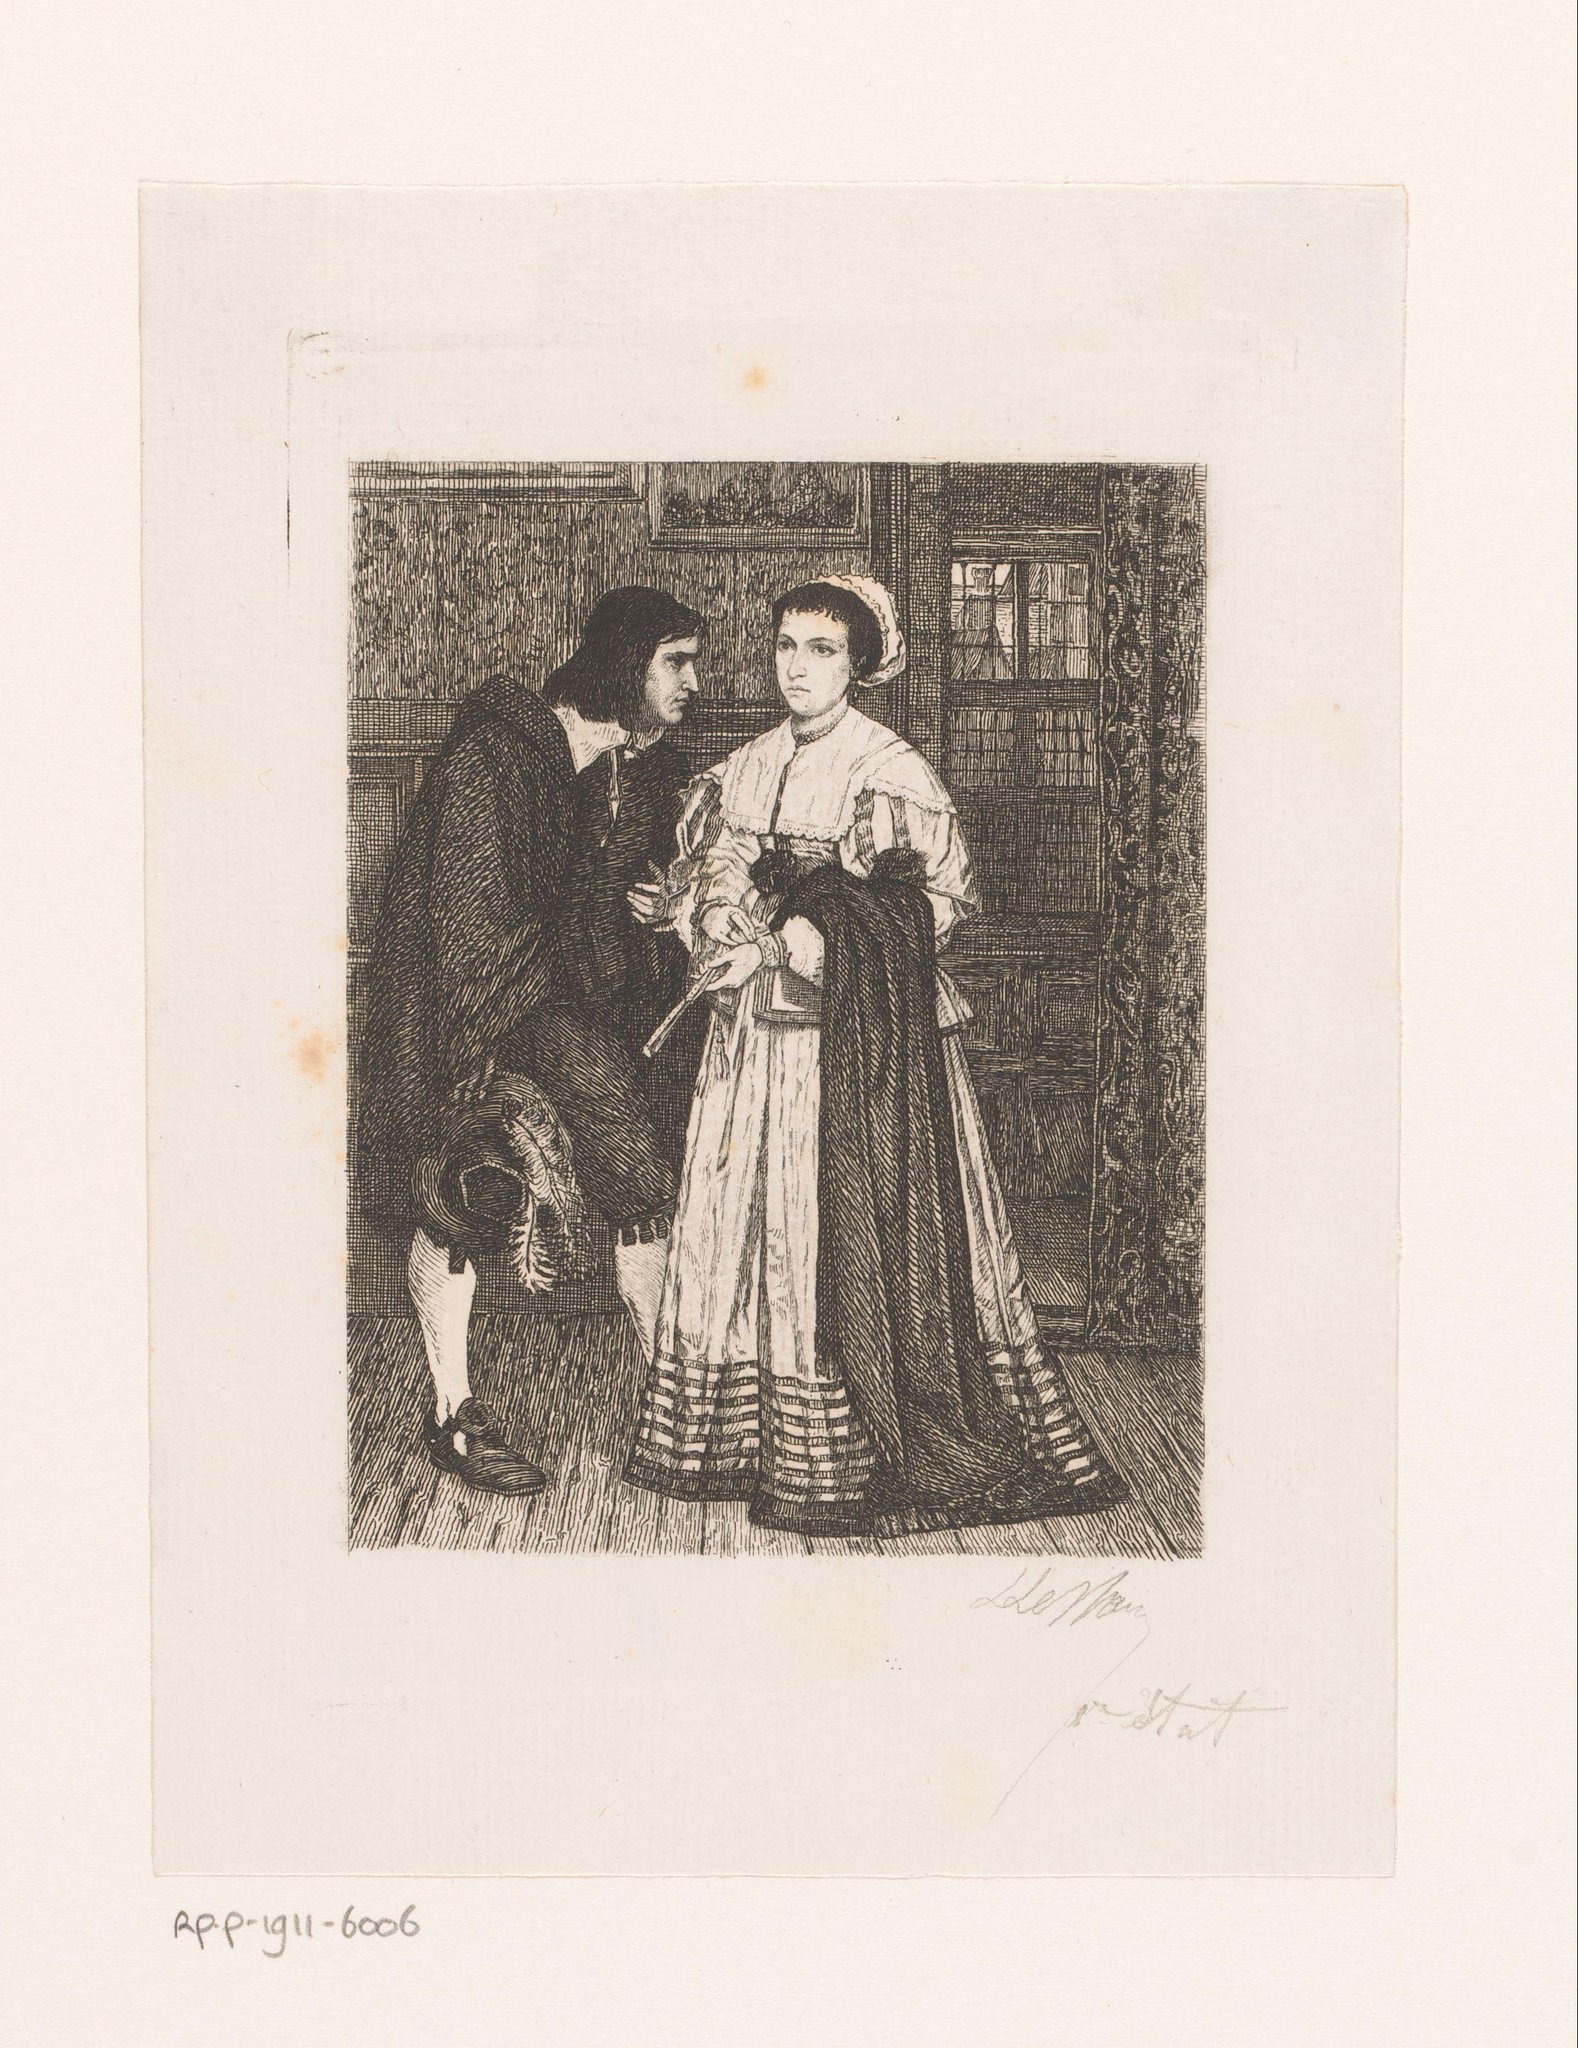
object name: print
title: La déclaration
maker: louis le nain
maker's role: print maker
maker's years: 1851-1939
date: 1863-1911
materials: paper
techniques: etching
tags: adult woman, adult man, historical costume, proposal, declaration of love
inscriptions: inscription: ‘LLeNain 1r Etat’, collector's mark: Lugt 2228